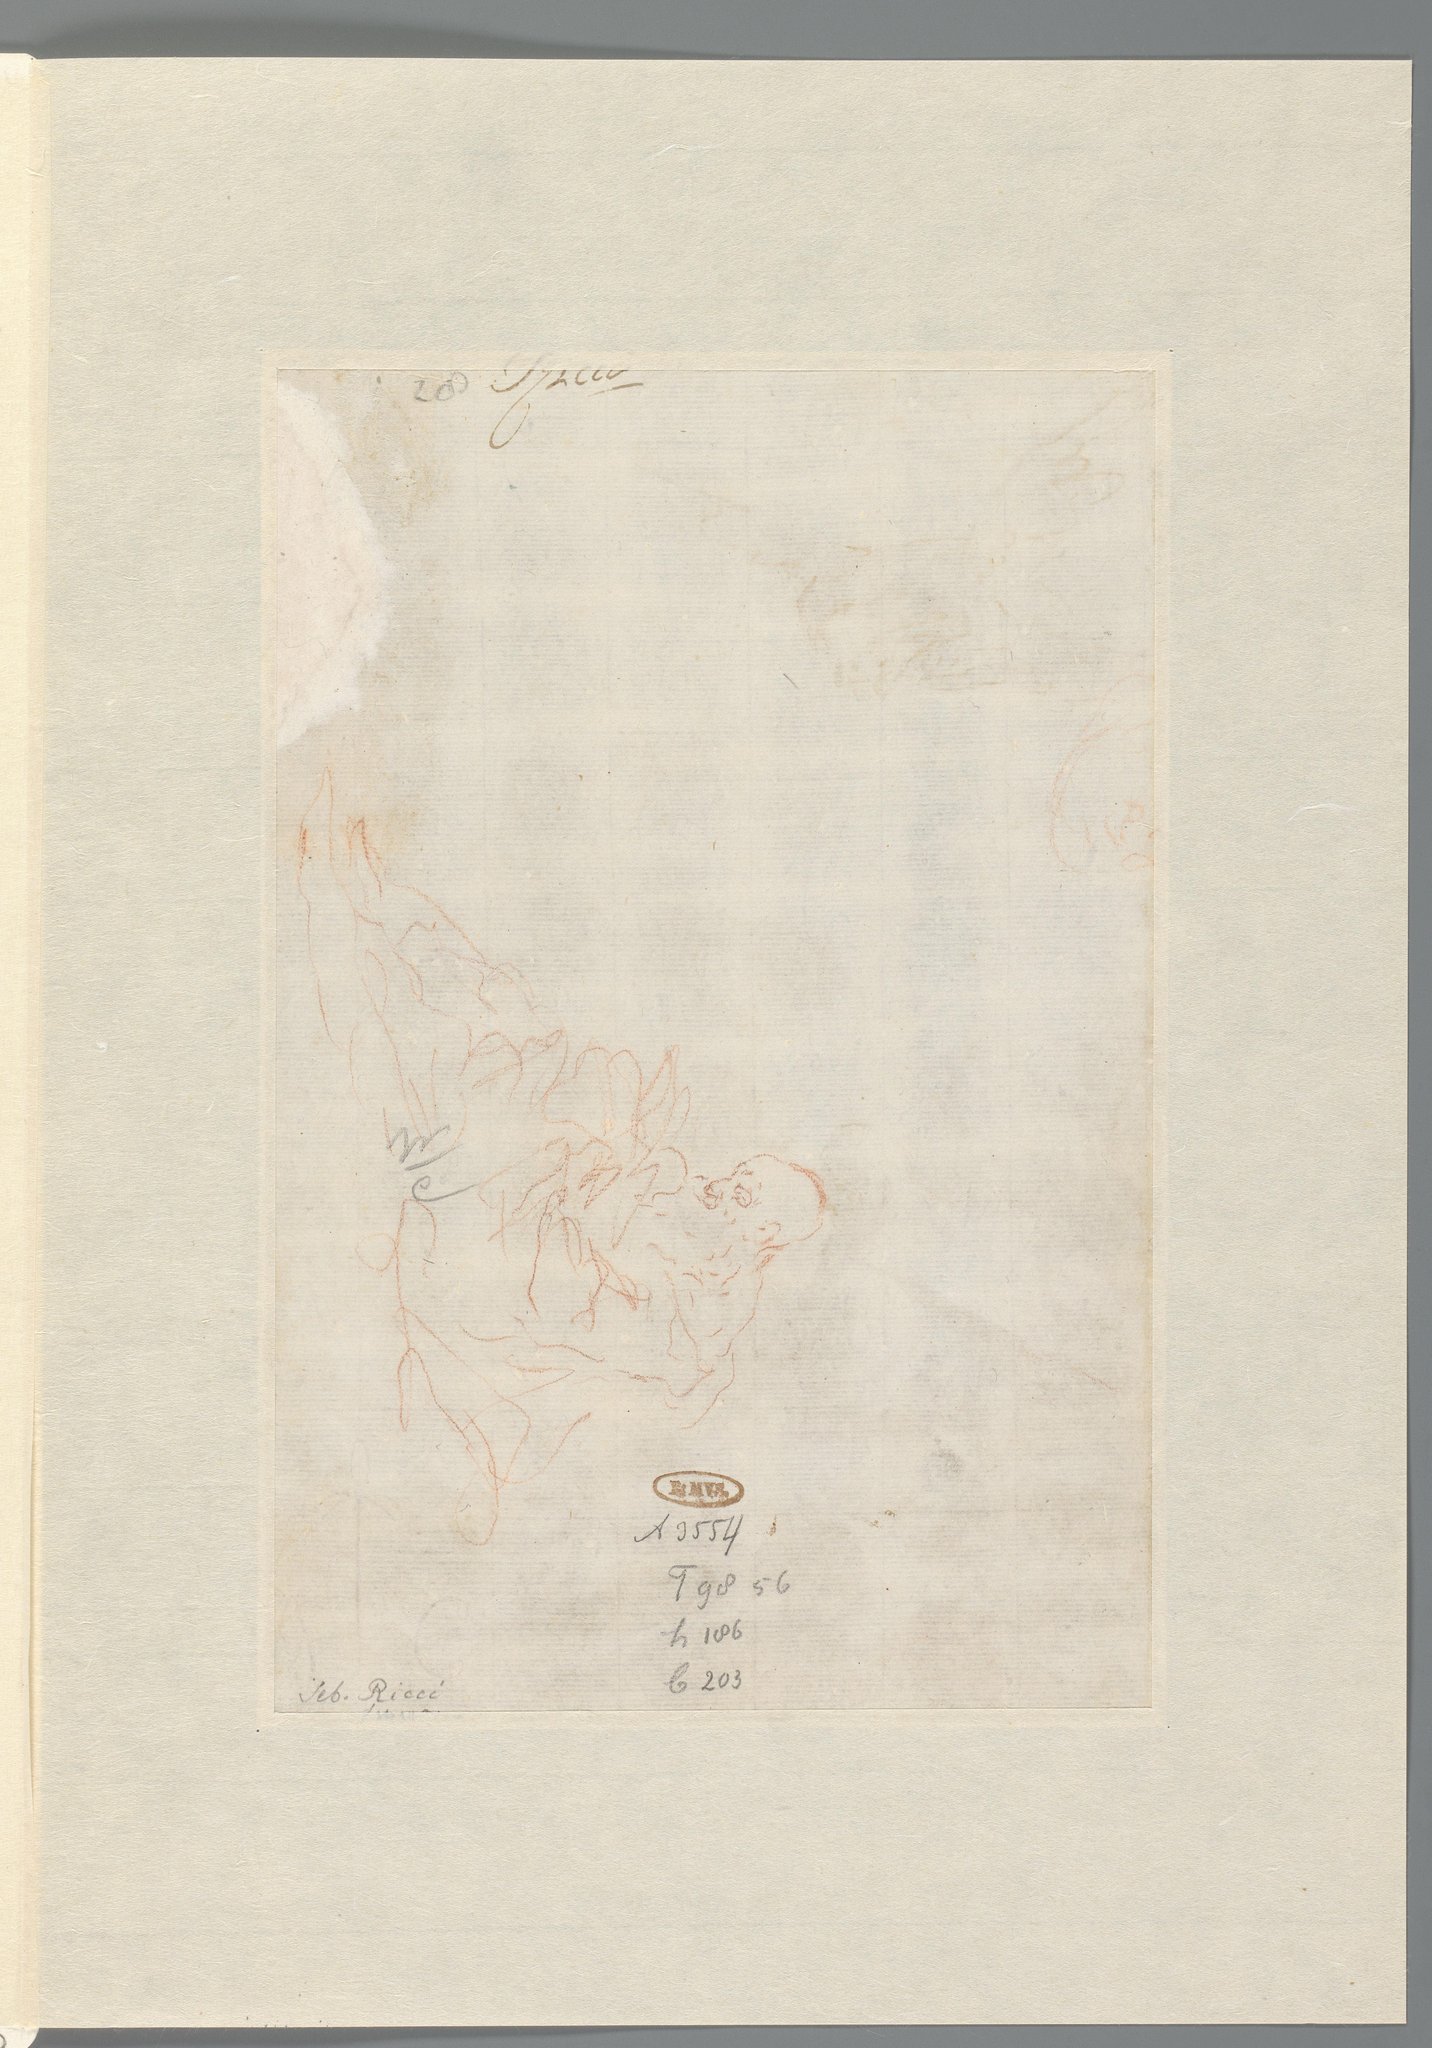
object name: drawing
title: Figuurstudie voor Elia gevoed door de raven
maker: gasparo diziani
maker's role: draughtsman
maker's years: 1689-1767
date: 1750-1760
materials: chalk, paper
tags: elijah fed by the raven(s): while the prophet is living by the brook, ravens bring him food